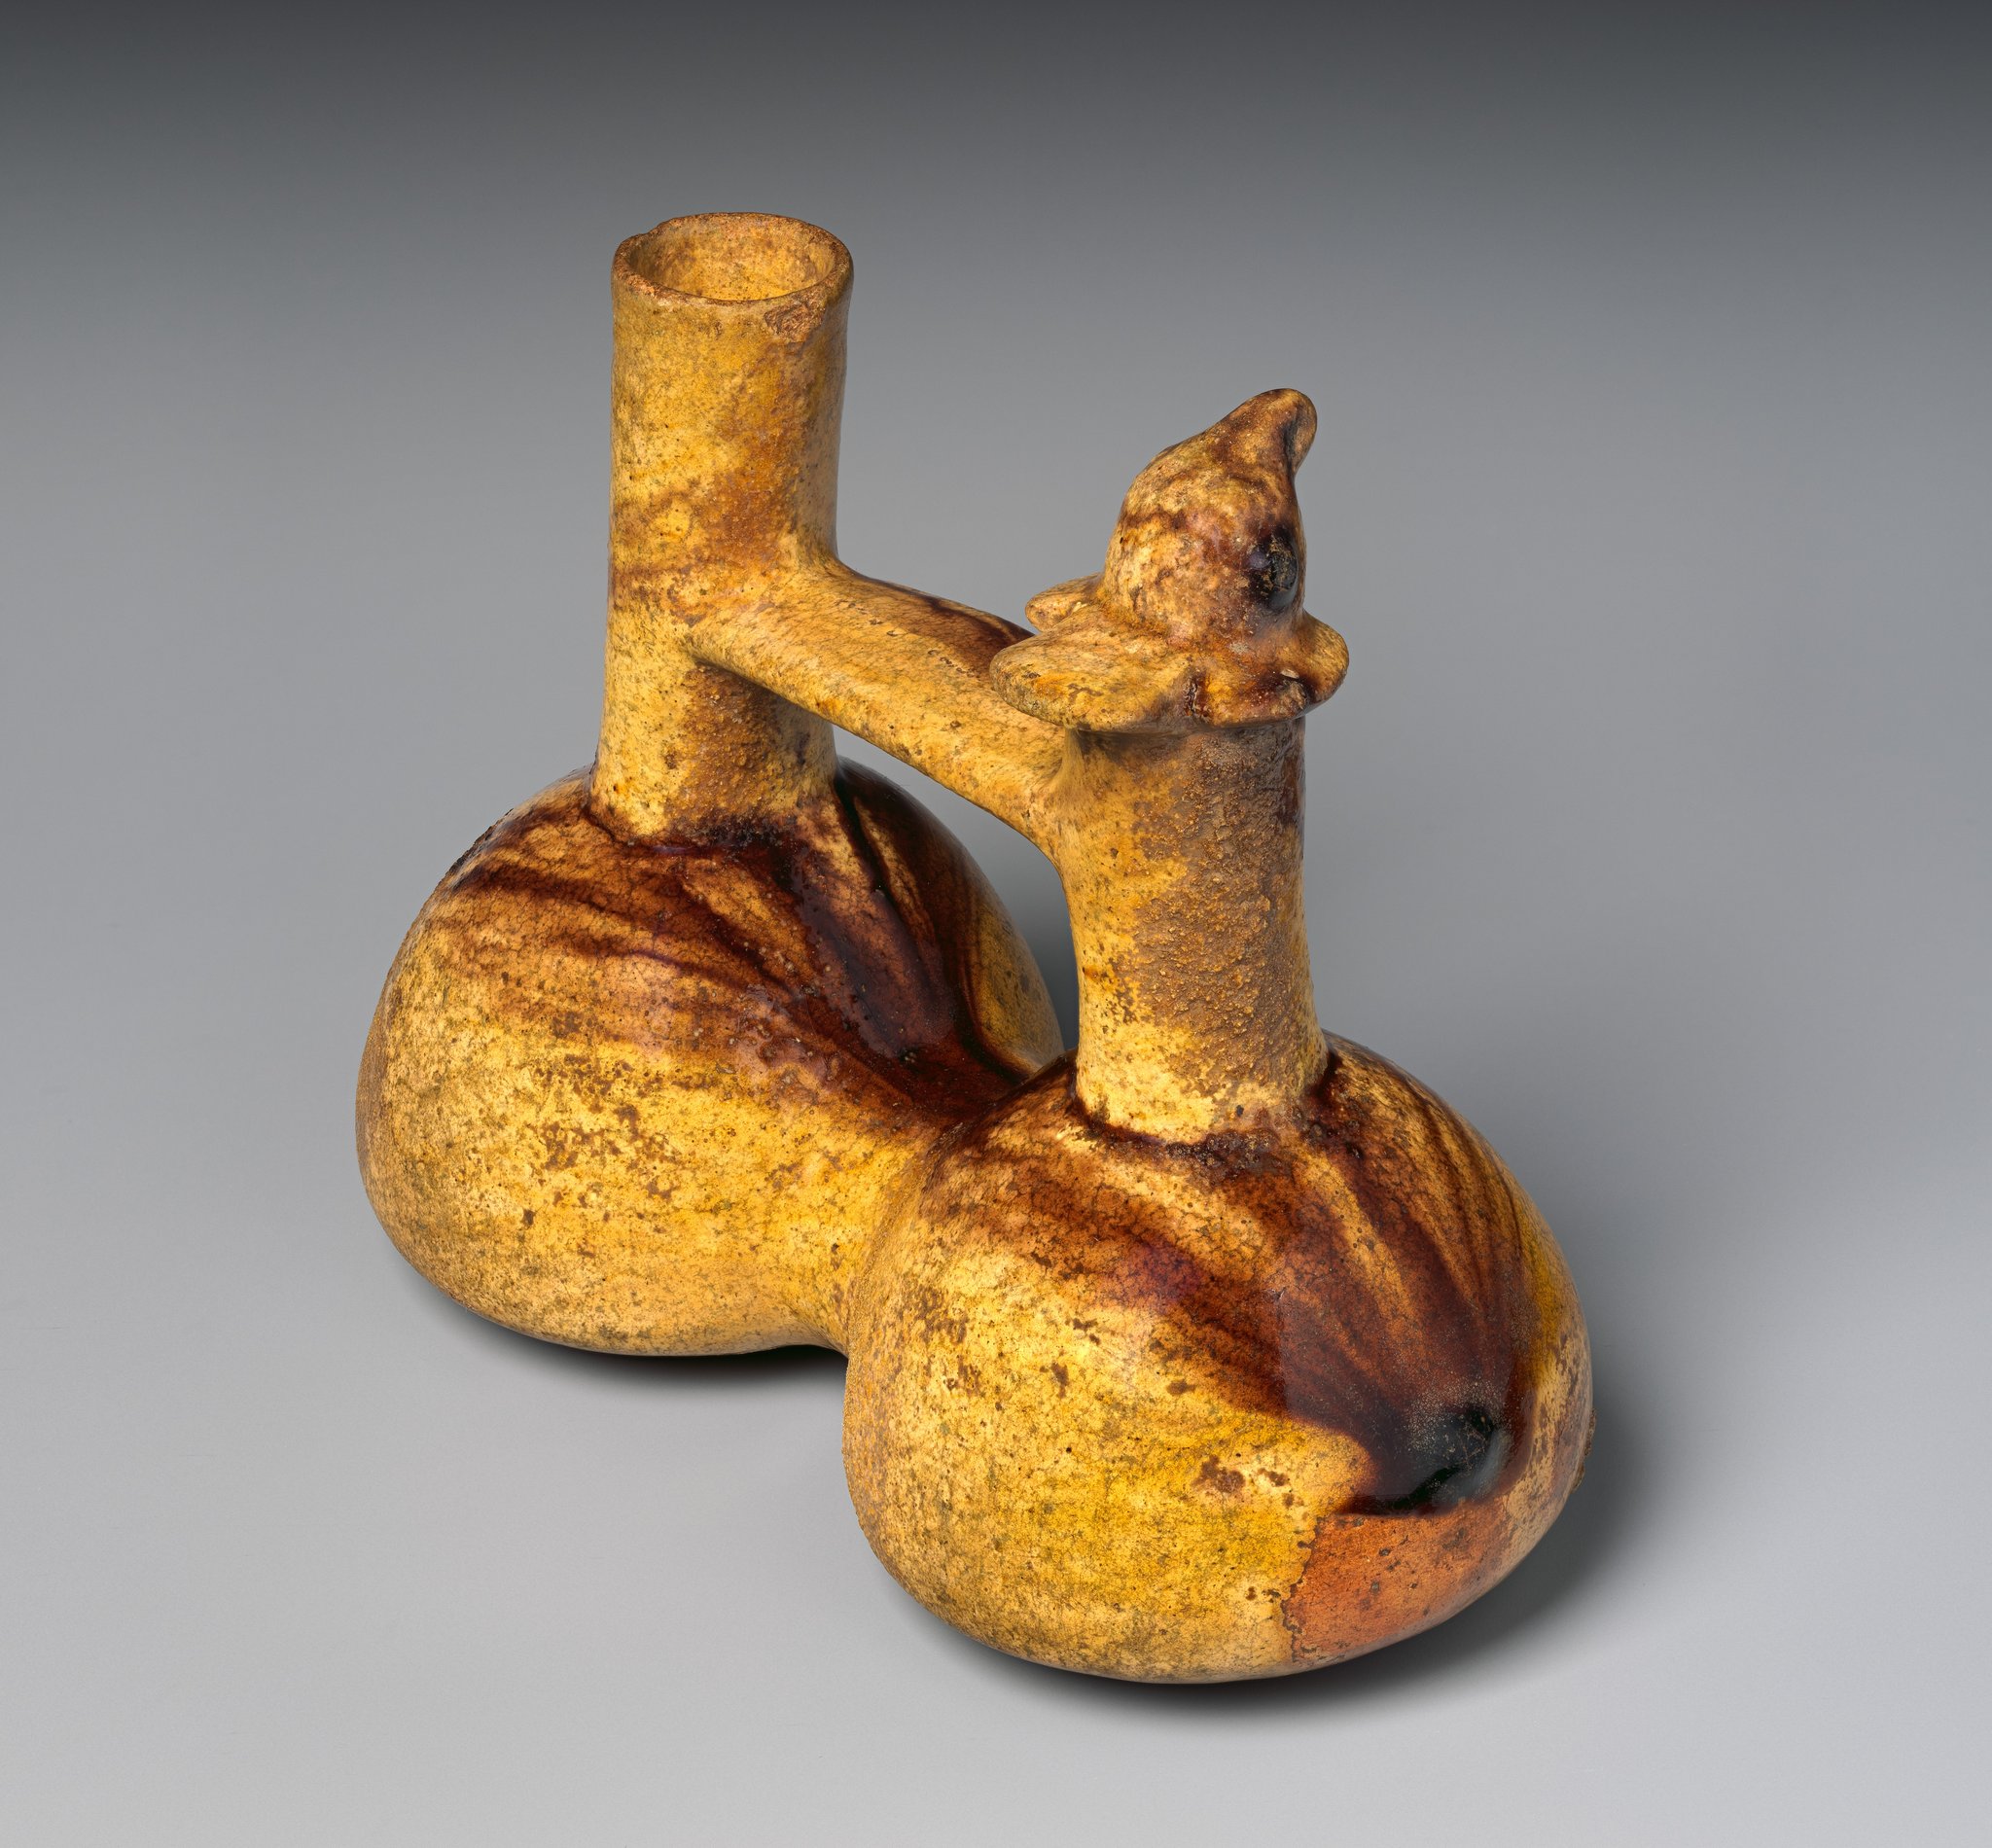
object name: bottle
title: Double-chambered bottle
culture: viceregal era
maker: peruvian artist(s)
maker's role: artist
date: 1601-1633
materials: ceramic, glaze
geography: peru